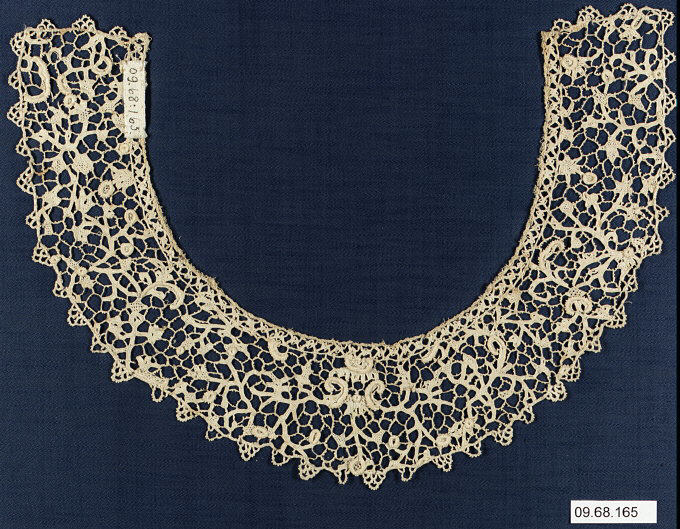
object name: collar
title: Small collar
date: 1667-1733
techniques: lace